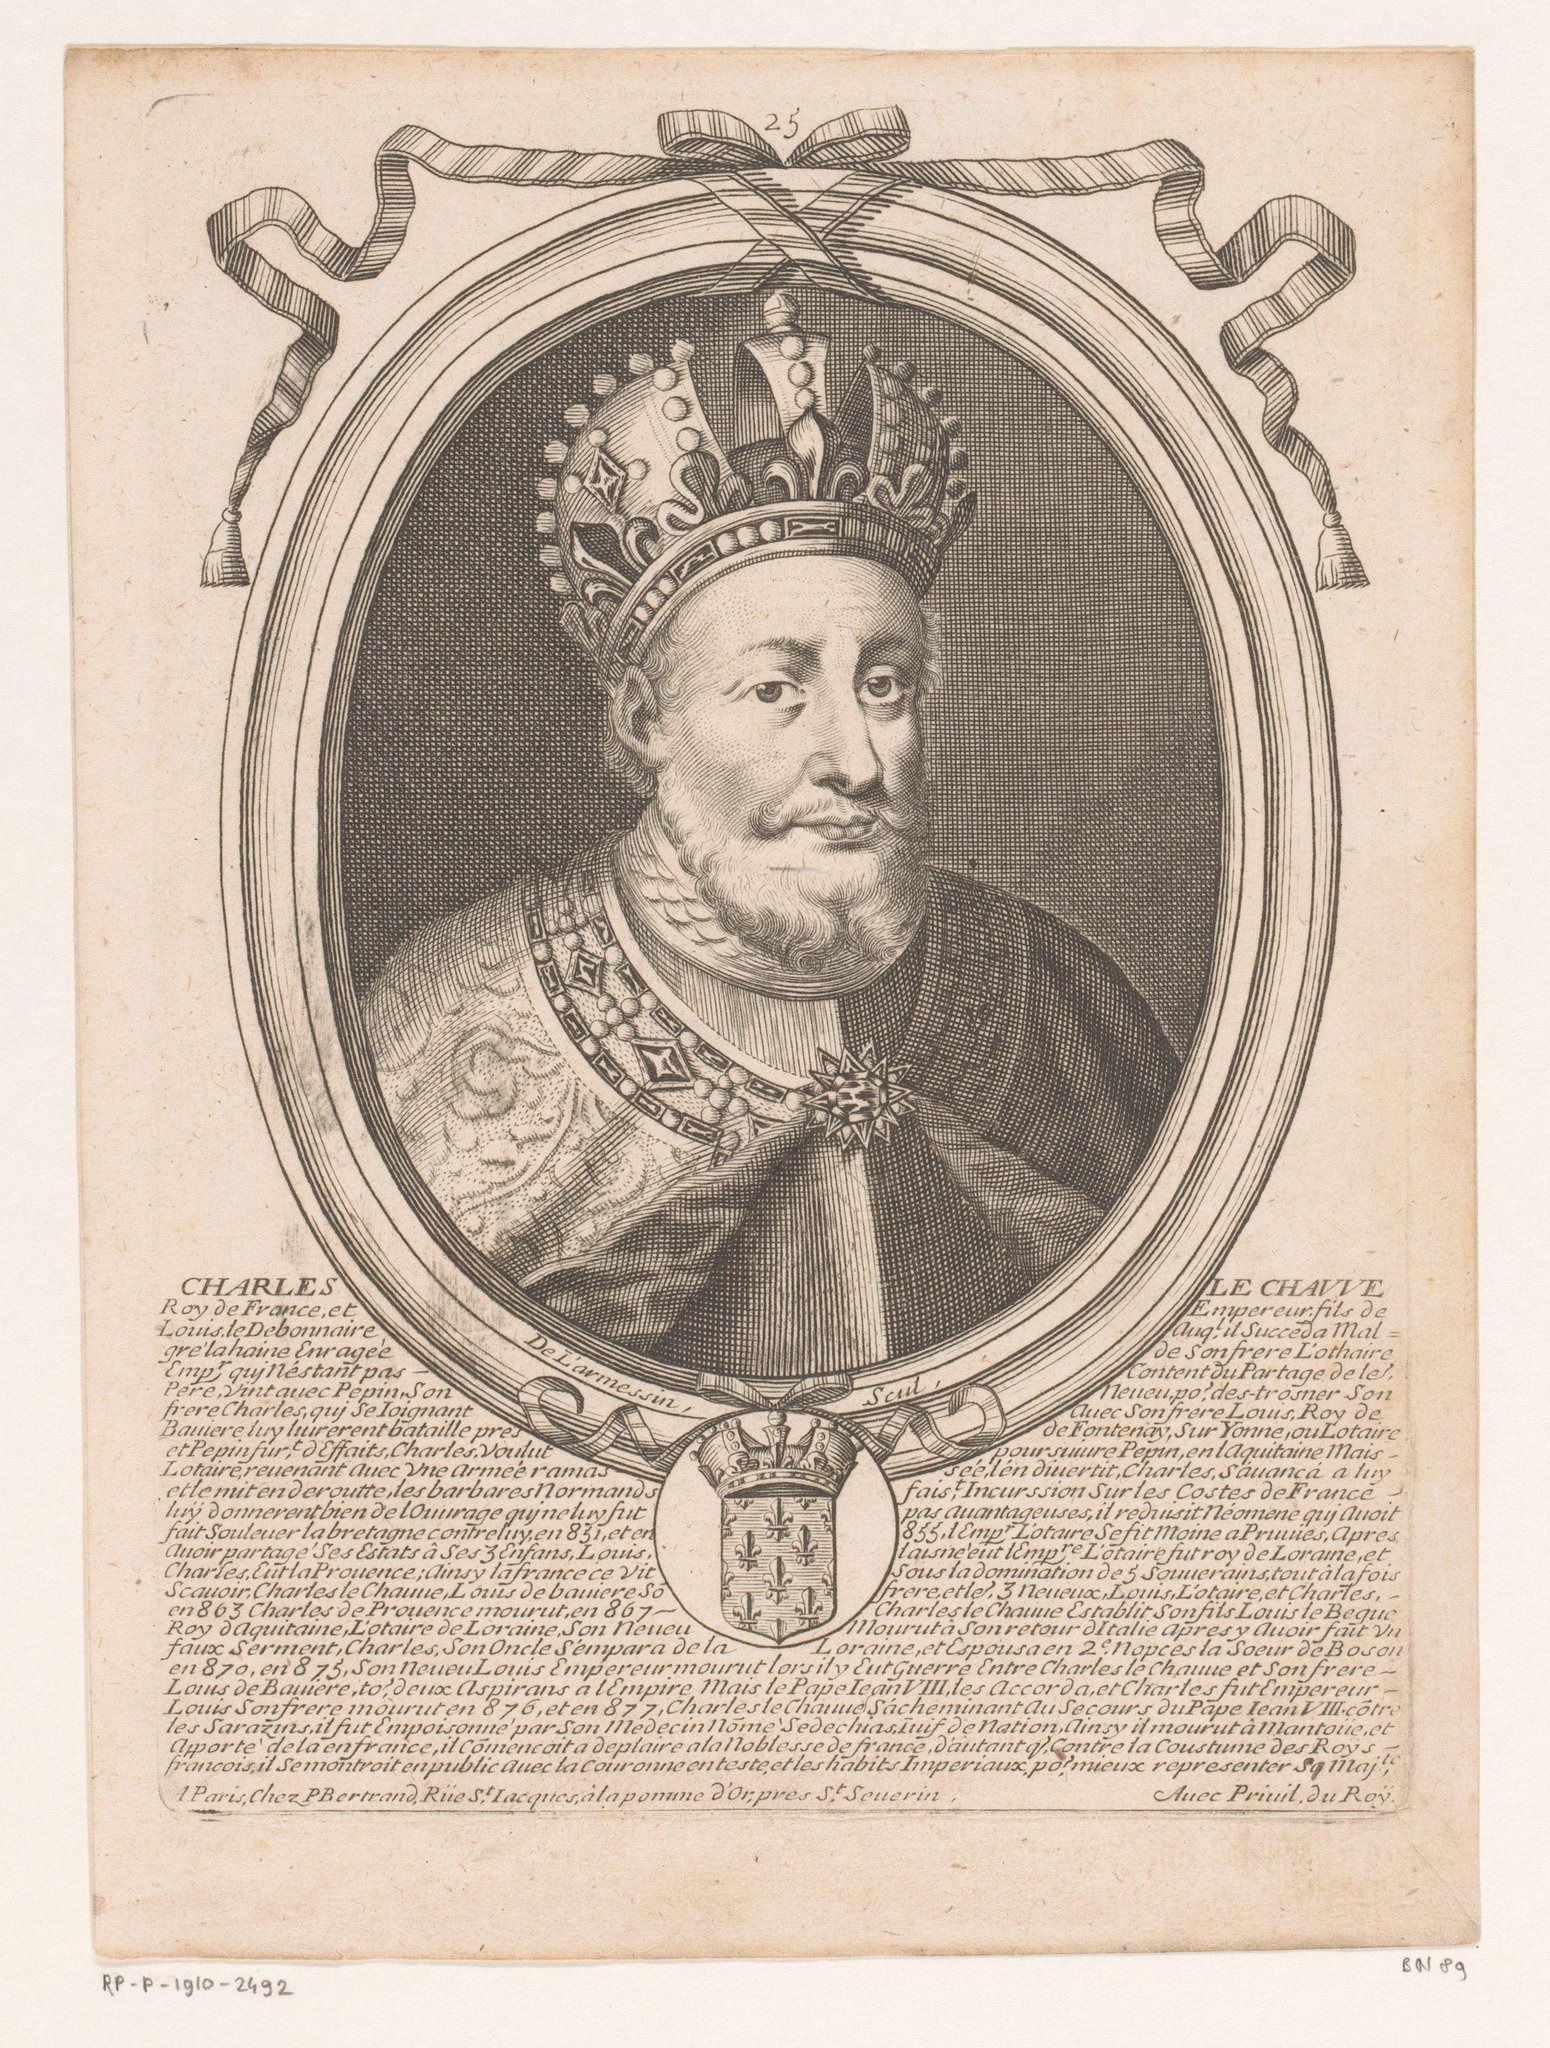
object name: print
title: Portretten van prominente figuren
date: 1642-1678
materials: paper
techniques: engraving, etching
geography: paris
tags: historical persons, emperor, king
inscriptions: collector's mark: Lugt 2228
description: Maakt deel uit van een grootschalige serie met portretten van prominente figuren. Binnen de serie bevindt zich een sectie getiteld 'Les Augustes Représentations De tous les Roys De France depuis Pharamond Iusqu'à Louys XIIII'. De serie werd respectievelijk uitgegeven door Pierre Bertrand, door zijn weduwe en door De Larmessin zelf.